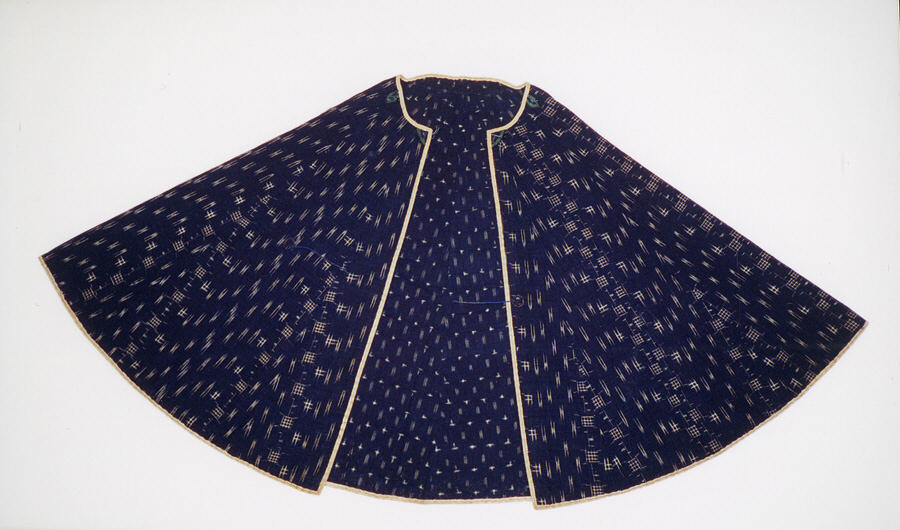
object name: cape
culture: japanese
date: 1801-1900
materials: cotton, paper, silk